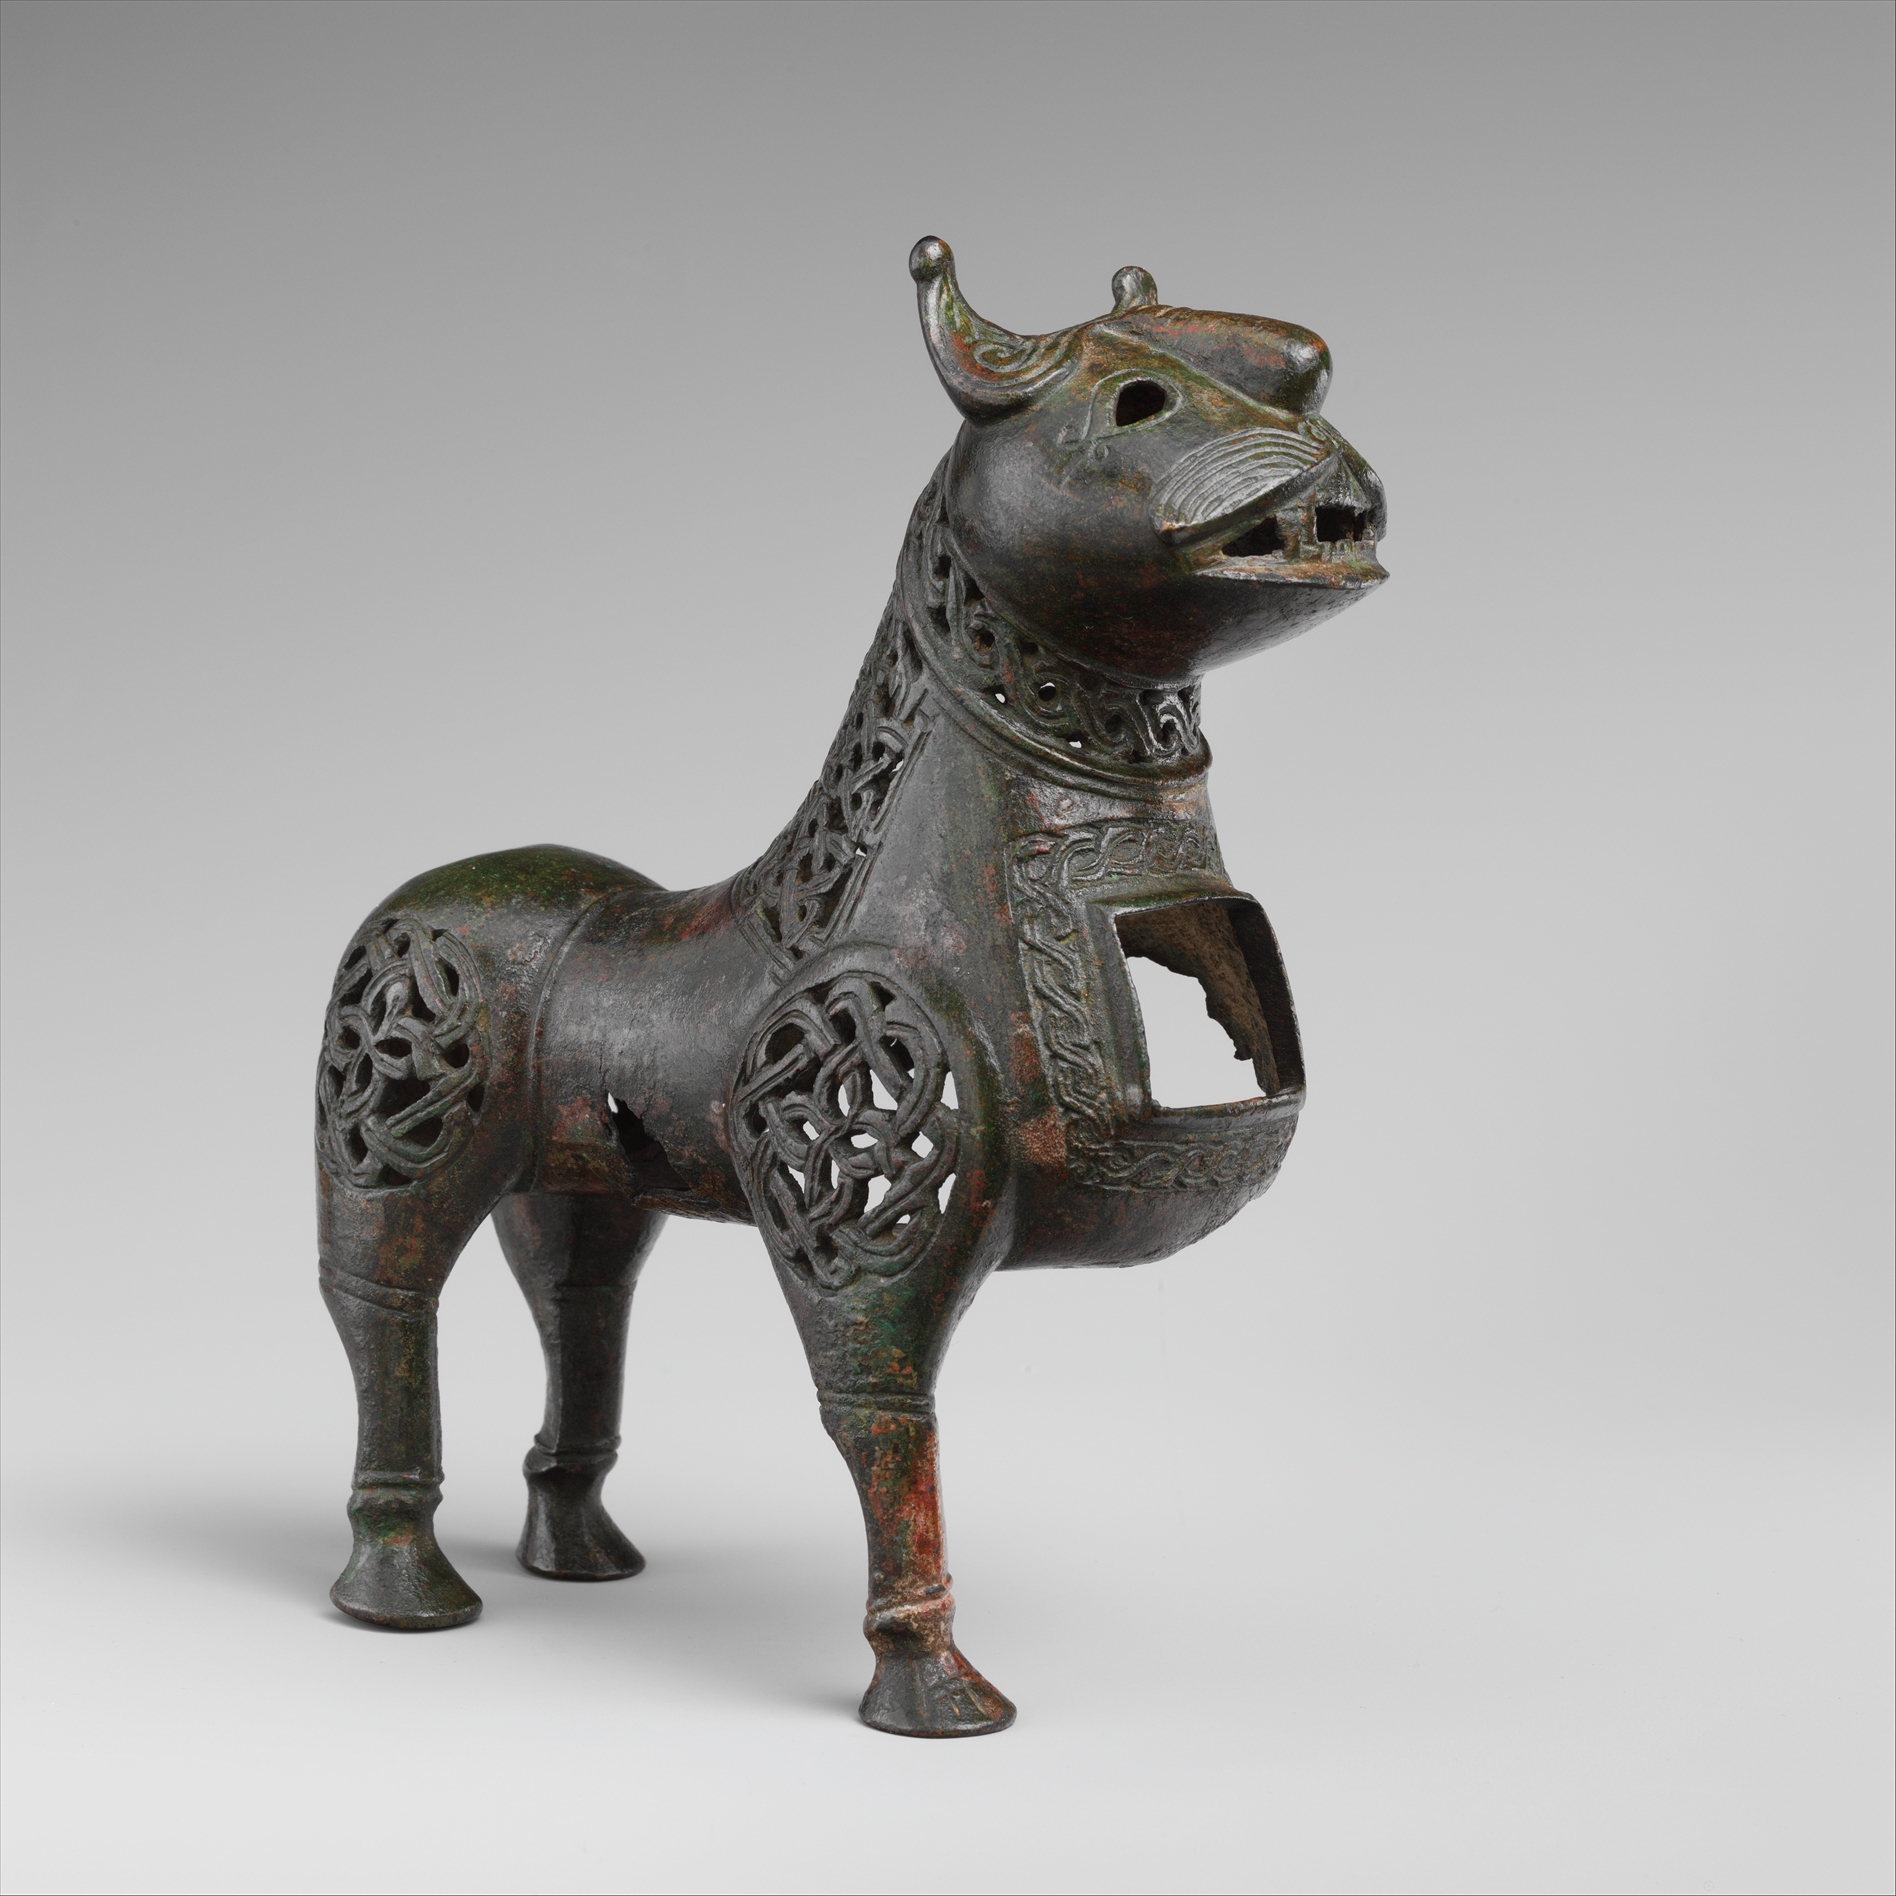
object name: incense burner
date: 1101-1200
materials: bronze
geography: iran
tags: animals